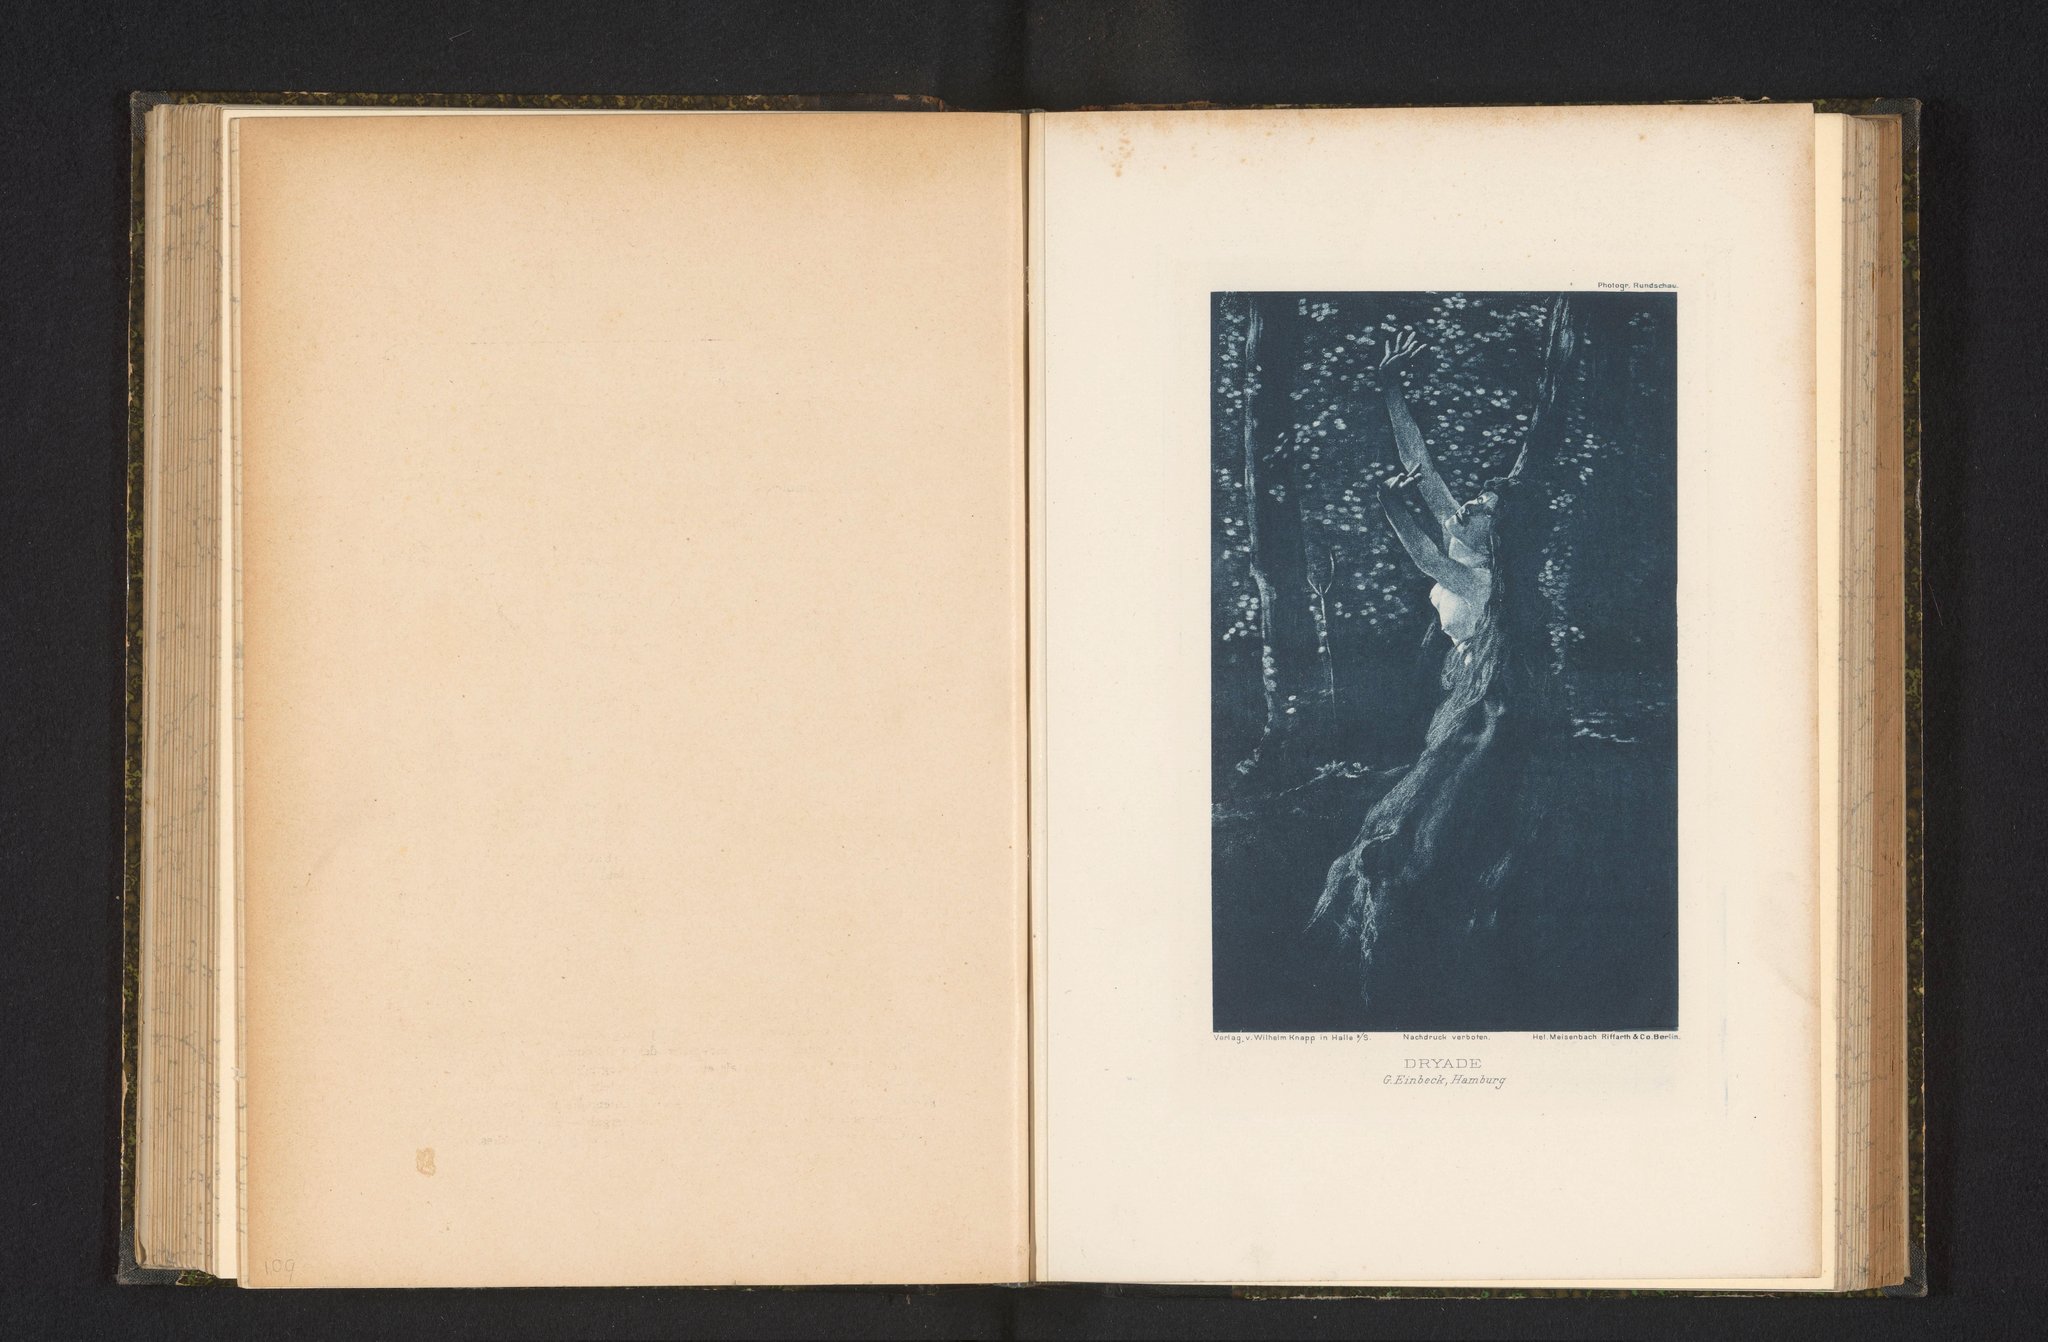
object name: photomechanical print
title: Dryade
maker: george einbeck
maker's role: painter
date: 1893-1898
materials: paper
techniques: photoaquatint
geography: halle an der saale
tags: (hama)dryads, forest- and tree-nymphs; 'driadi & hamadriadi' (ripa)